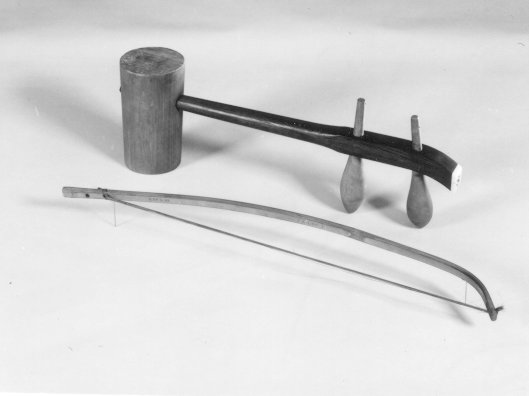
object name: erxian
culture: chinese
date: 1801-1900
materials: bamboo, hair, plastic, wood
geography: china